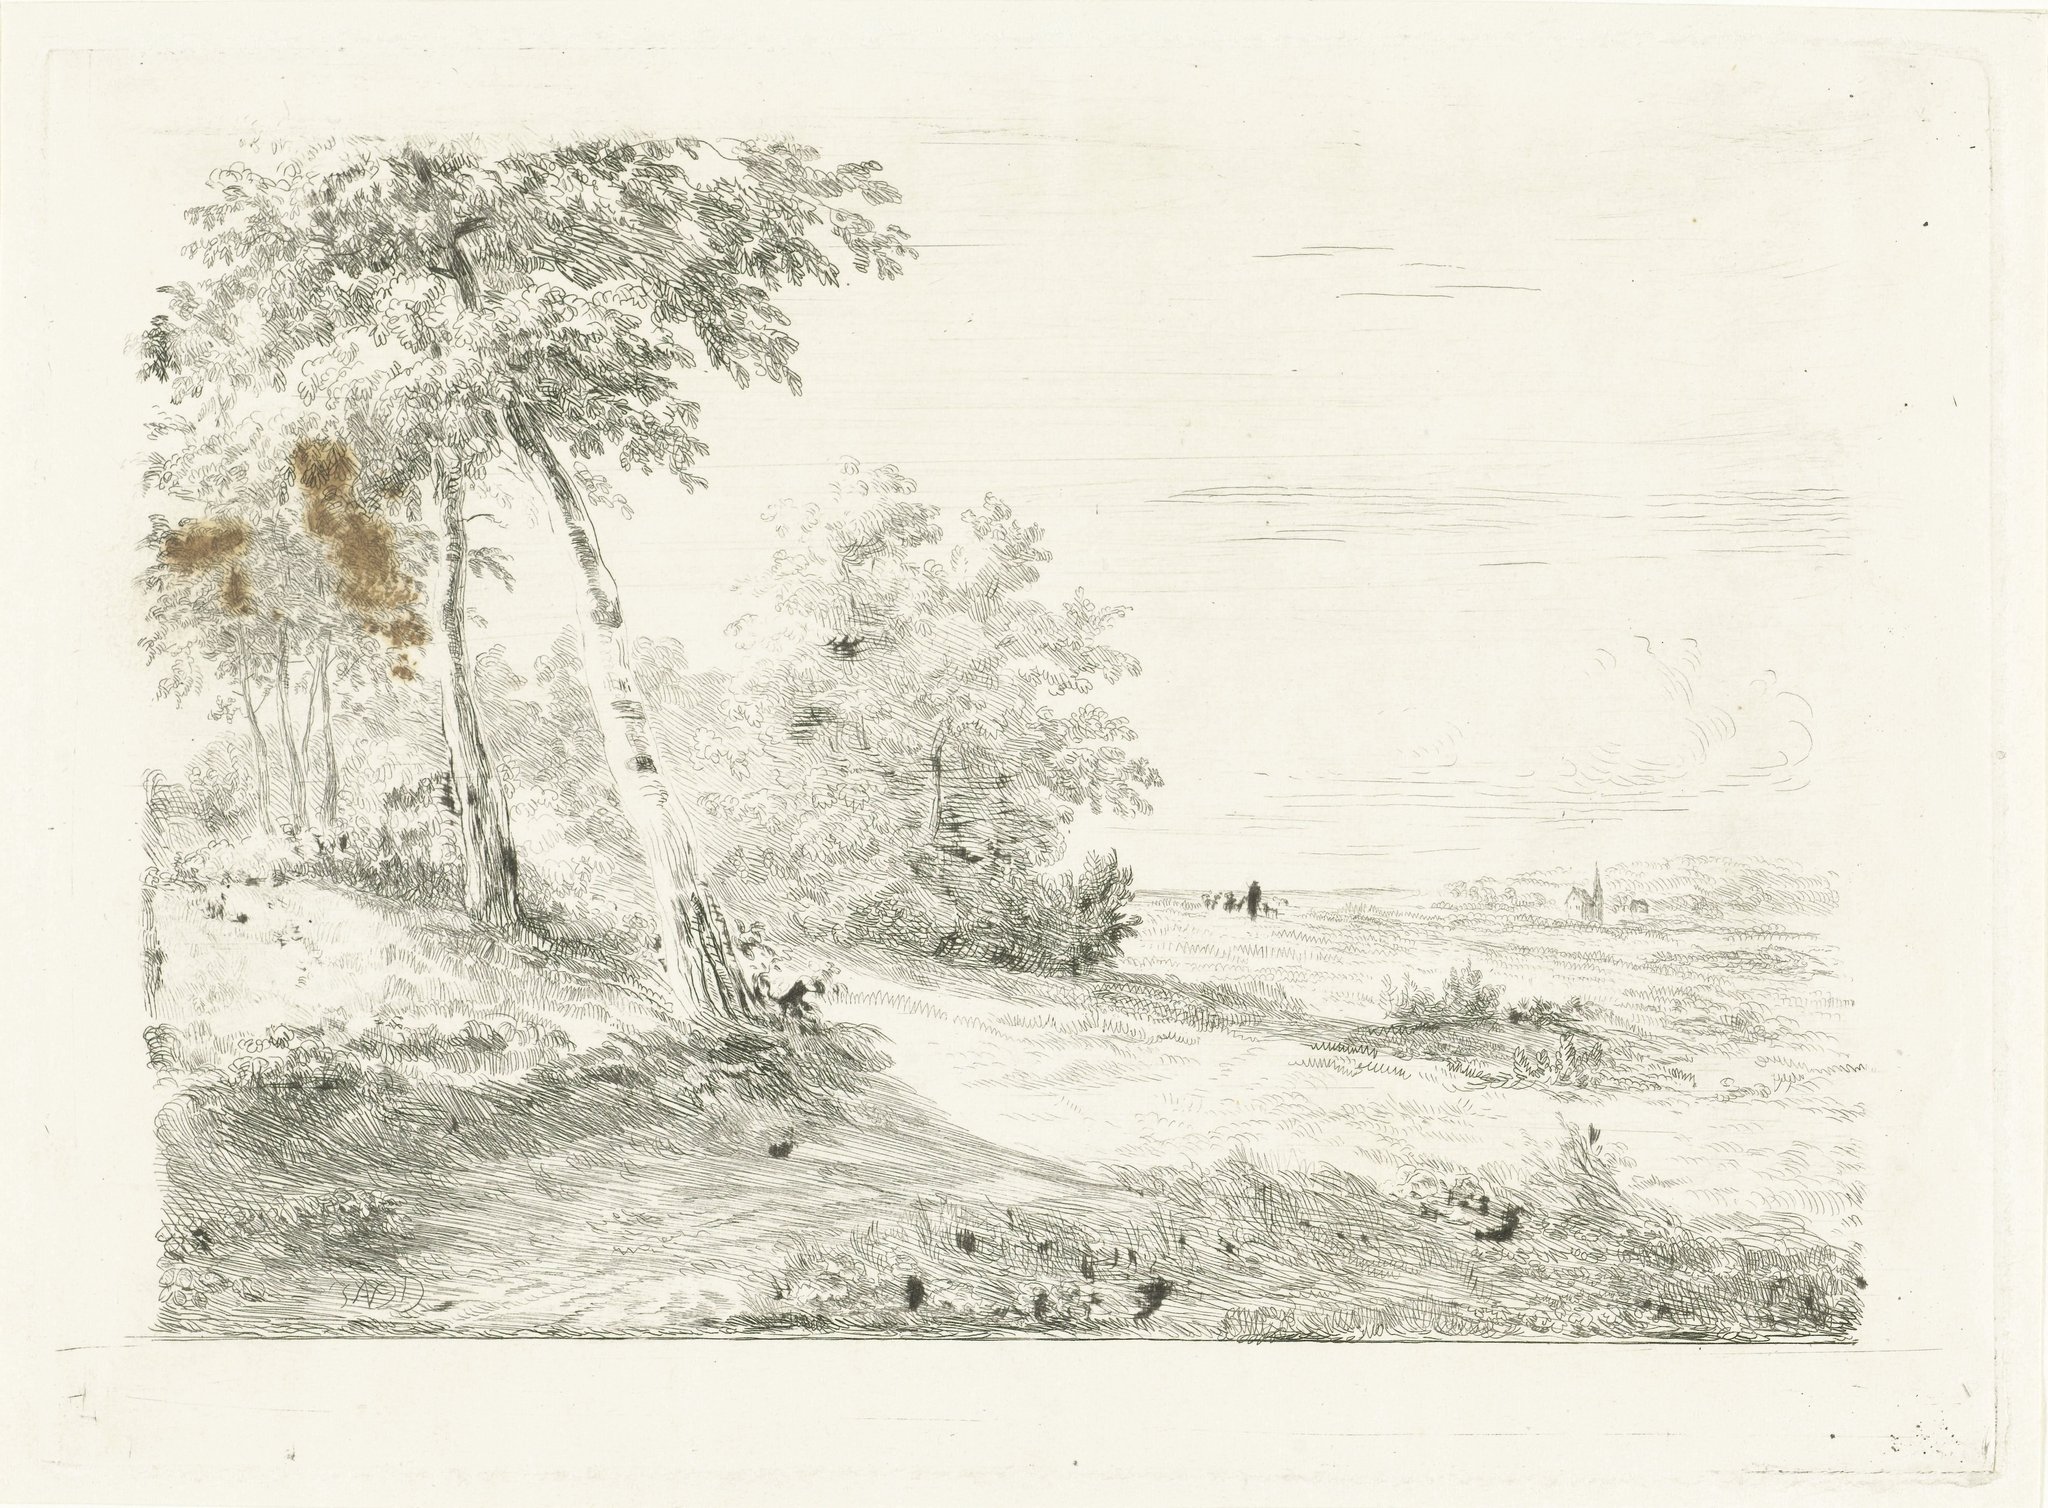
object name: print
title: Landschap met een schaapherder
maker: johannes adrianus van der drift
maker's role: print maker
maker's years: 1808-1883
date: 1823-1883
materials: paper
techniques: etching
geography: netherlands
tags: herding, herdsman, herdswoman, shepherd, shepherdess, cowherd, etc., landscapes in the temperate zone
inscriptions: collector's mark: Lugt 2228